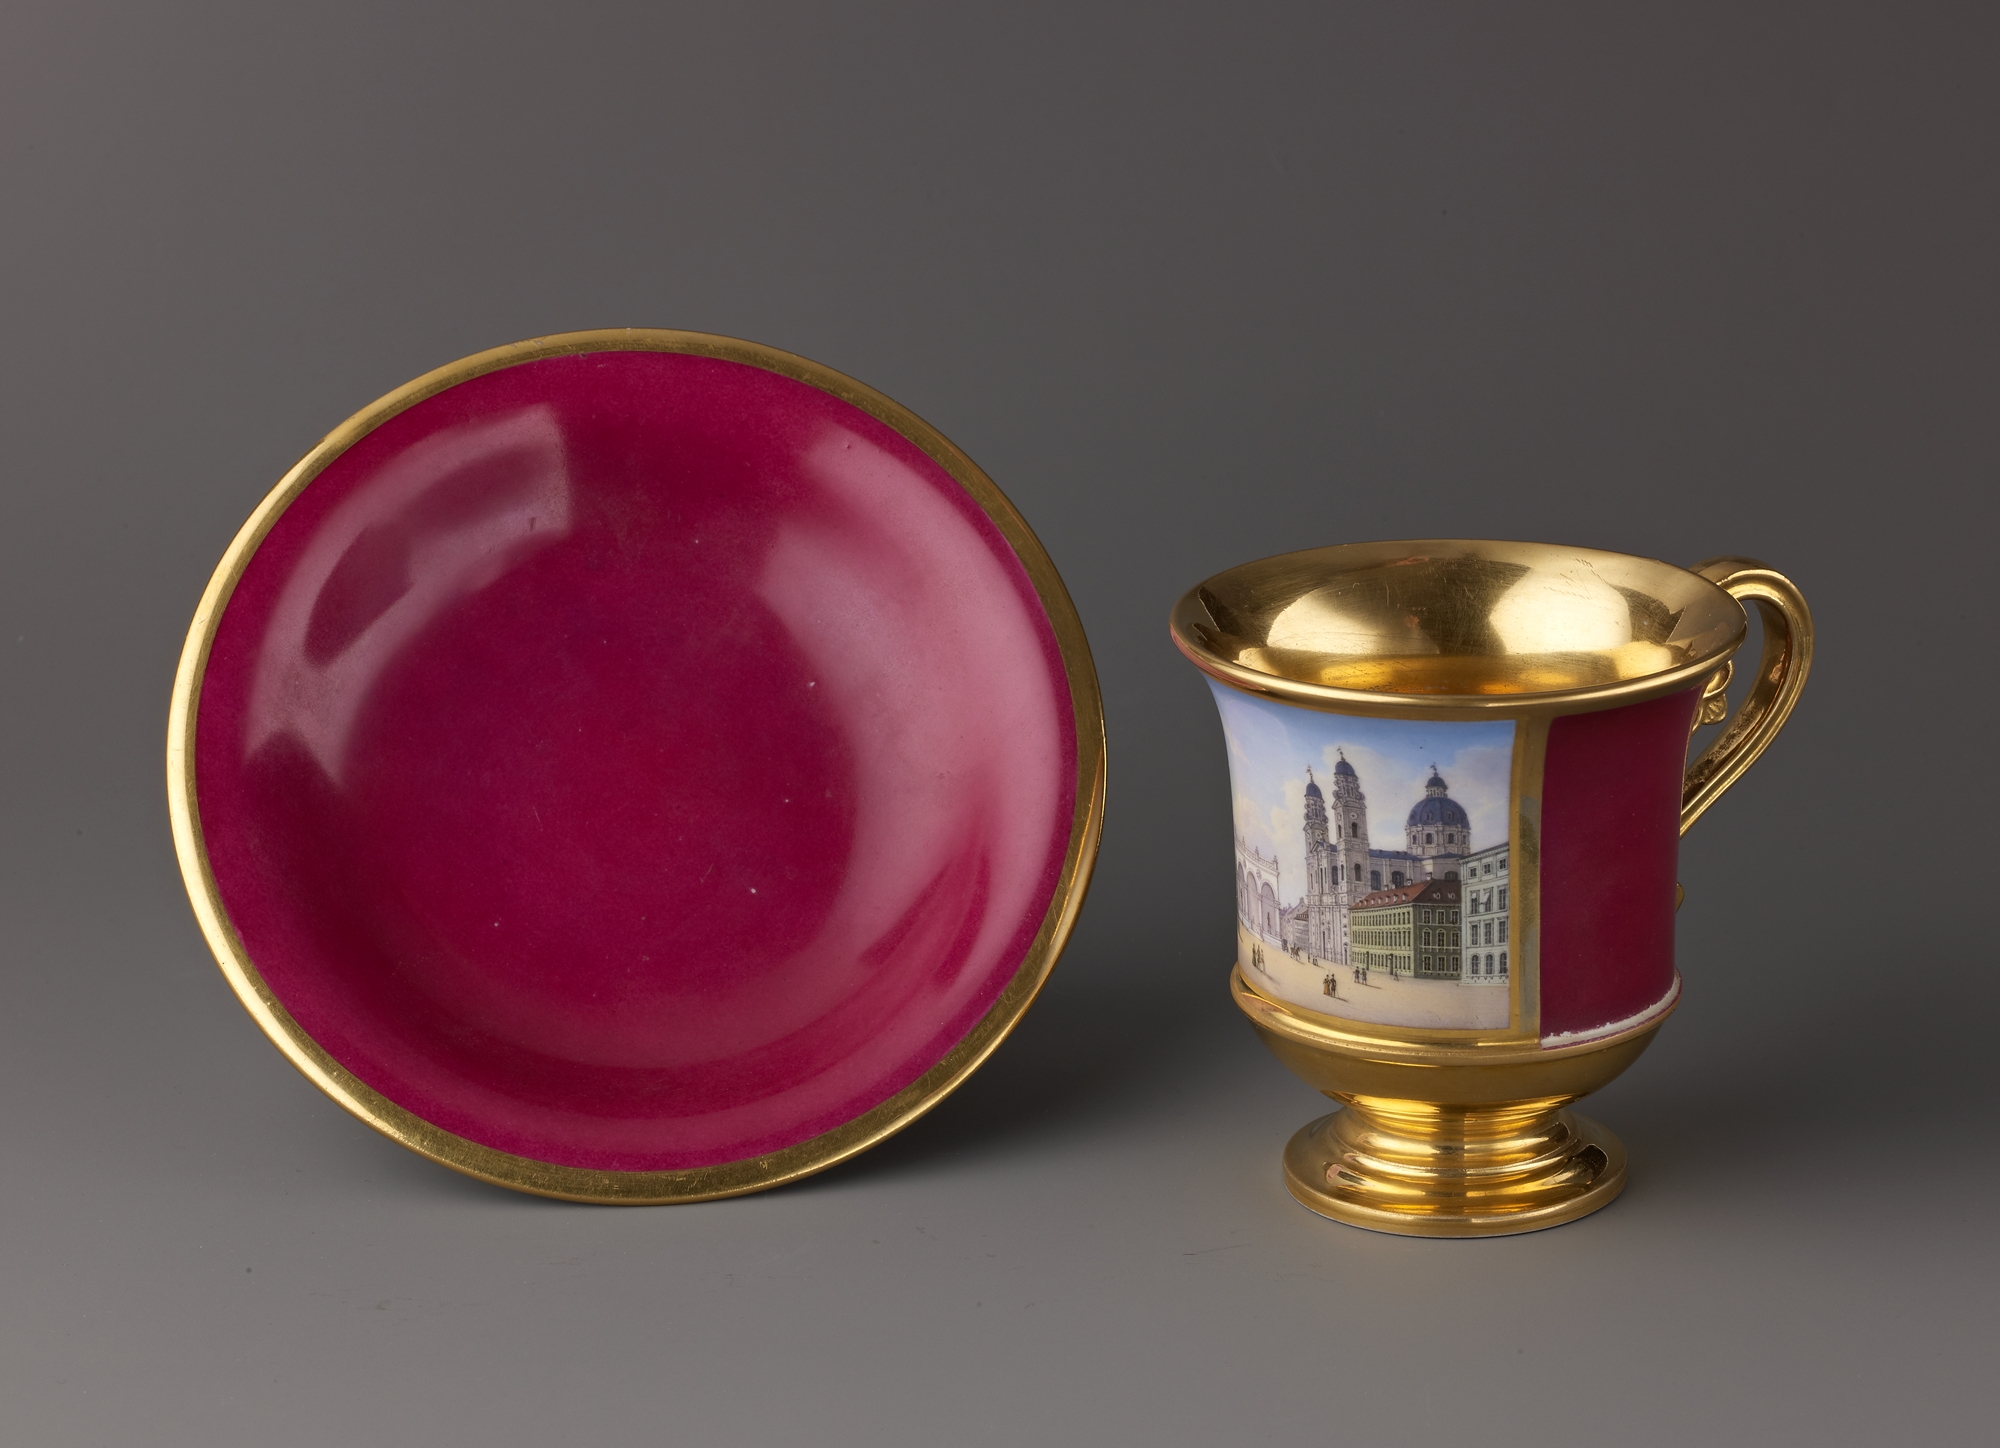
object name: cup and saucer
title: Cup (with a view of the Odeonsplatz, Munich) and saucer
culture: german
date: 1845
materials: hard paste porcelain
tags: buildings